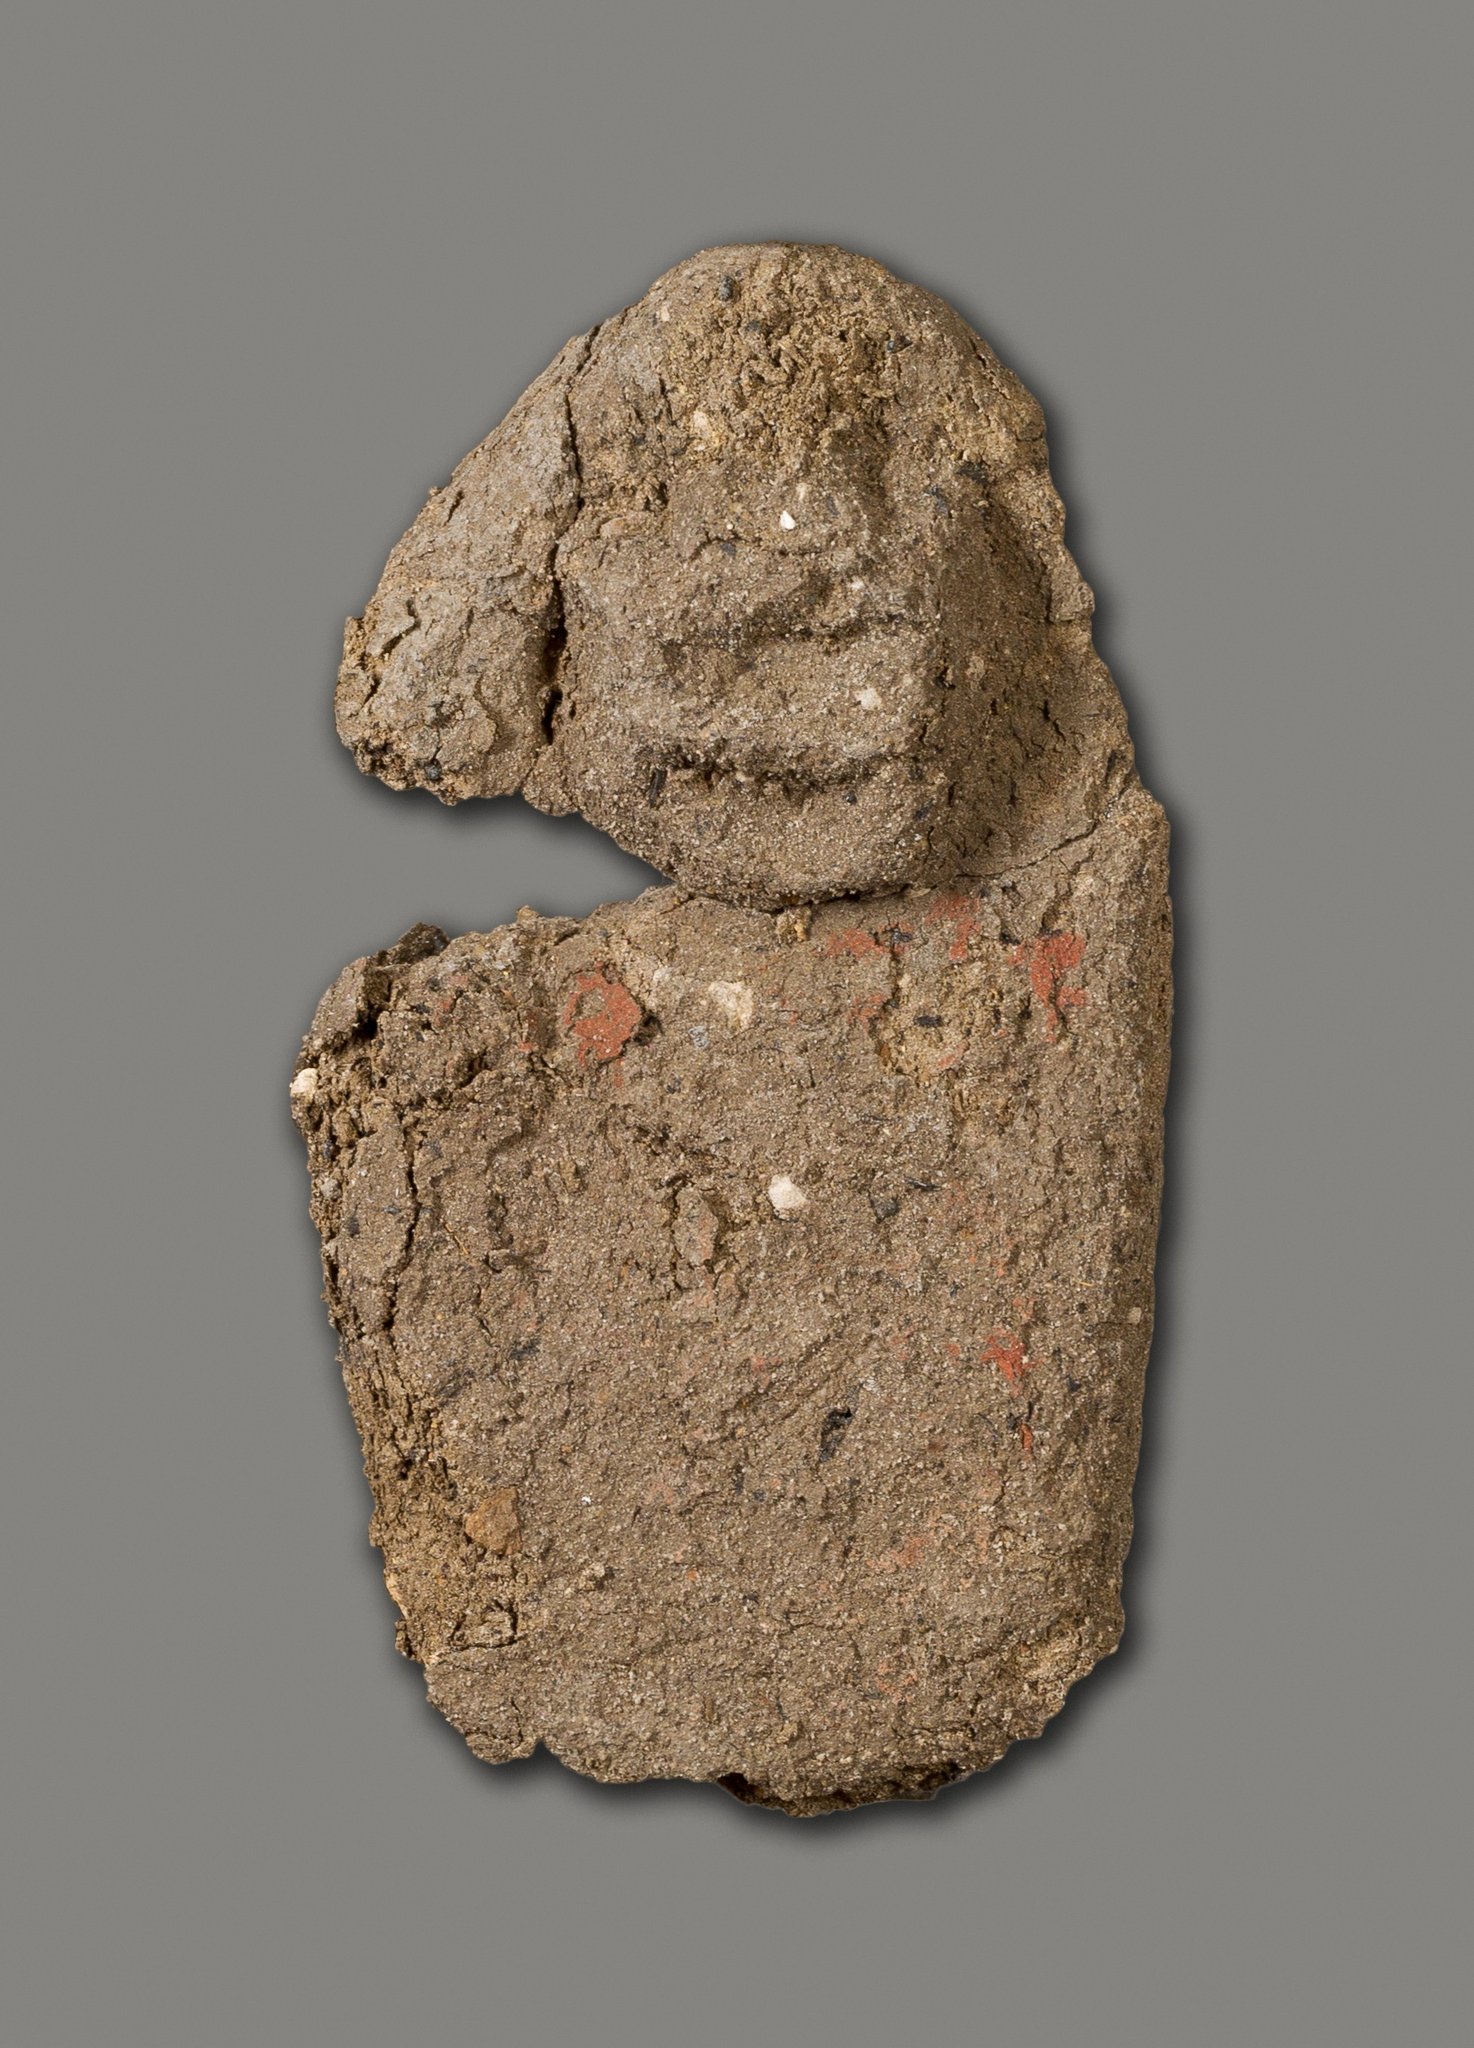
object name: figure, magical, execration, tablet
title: Magical Figure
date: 1802-1550 BCE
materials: clay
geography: egypt